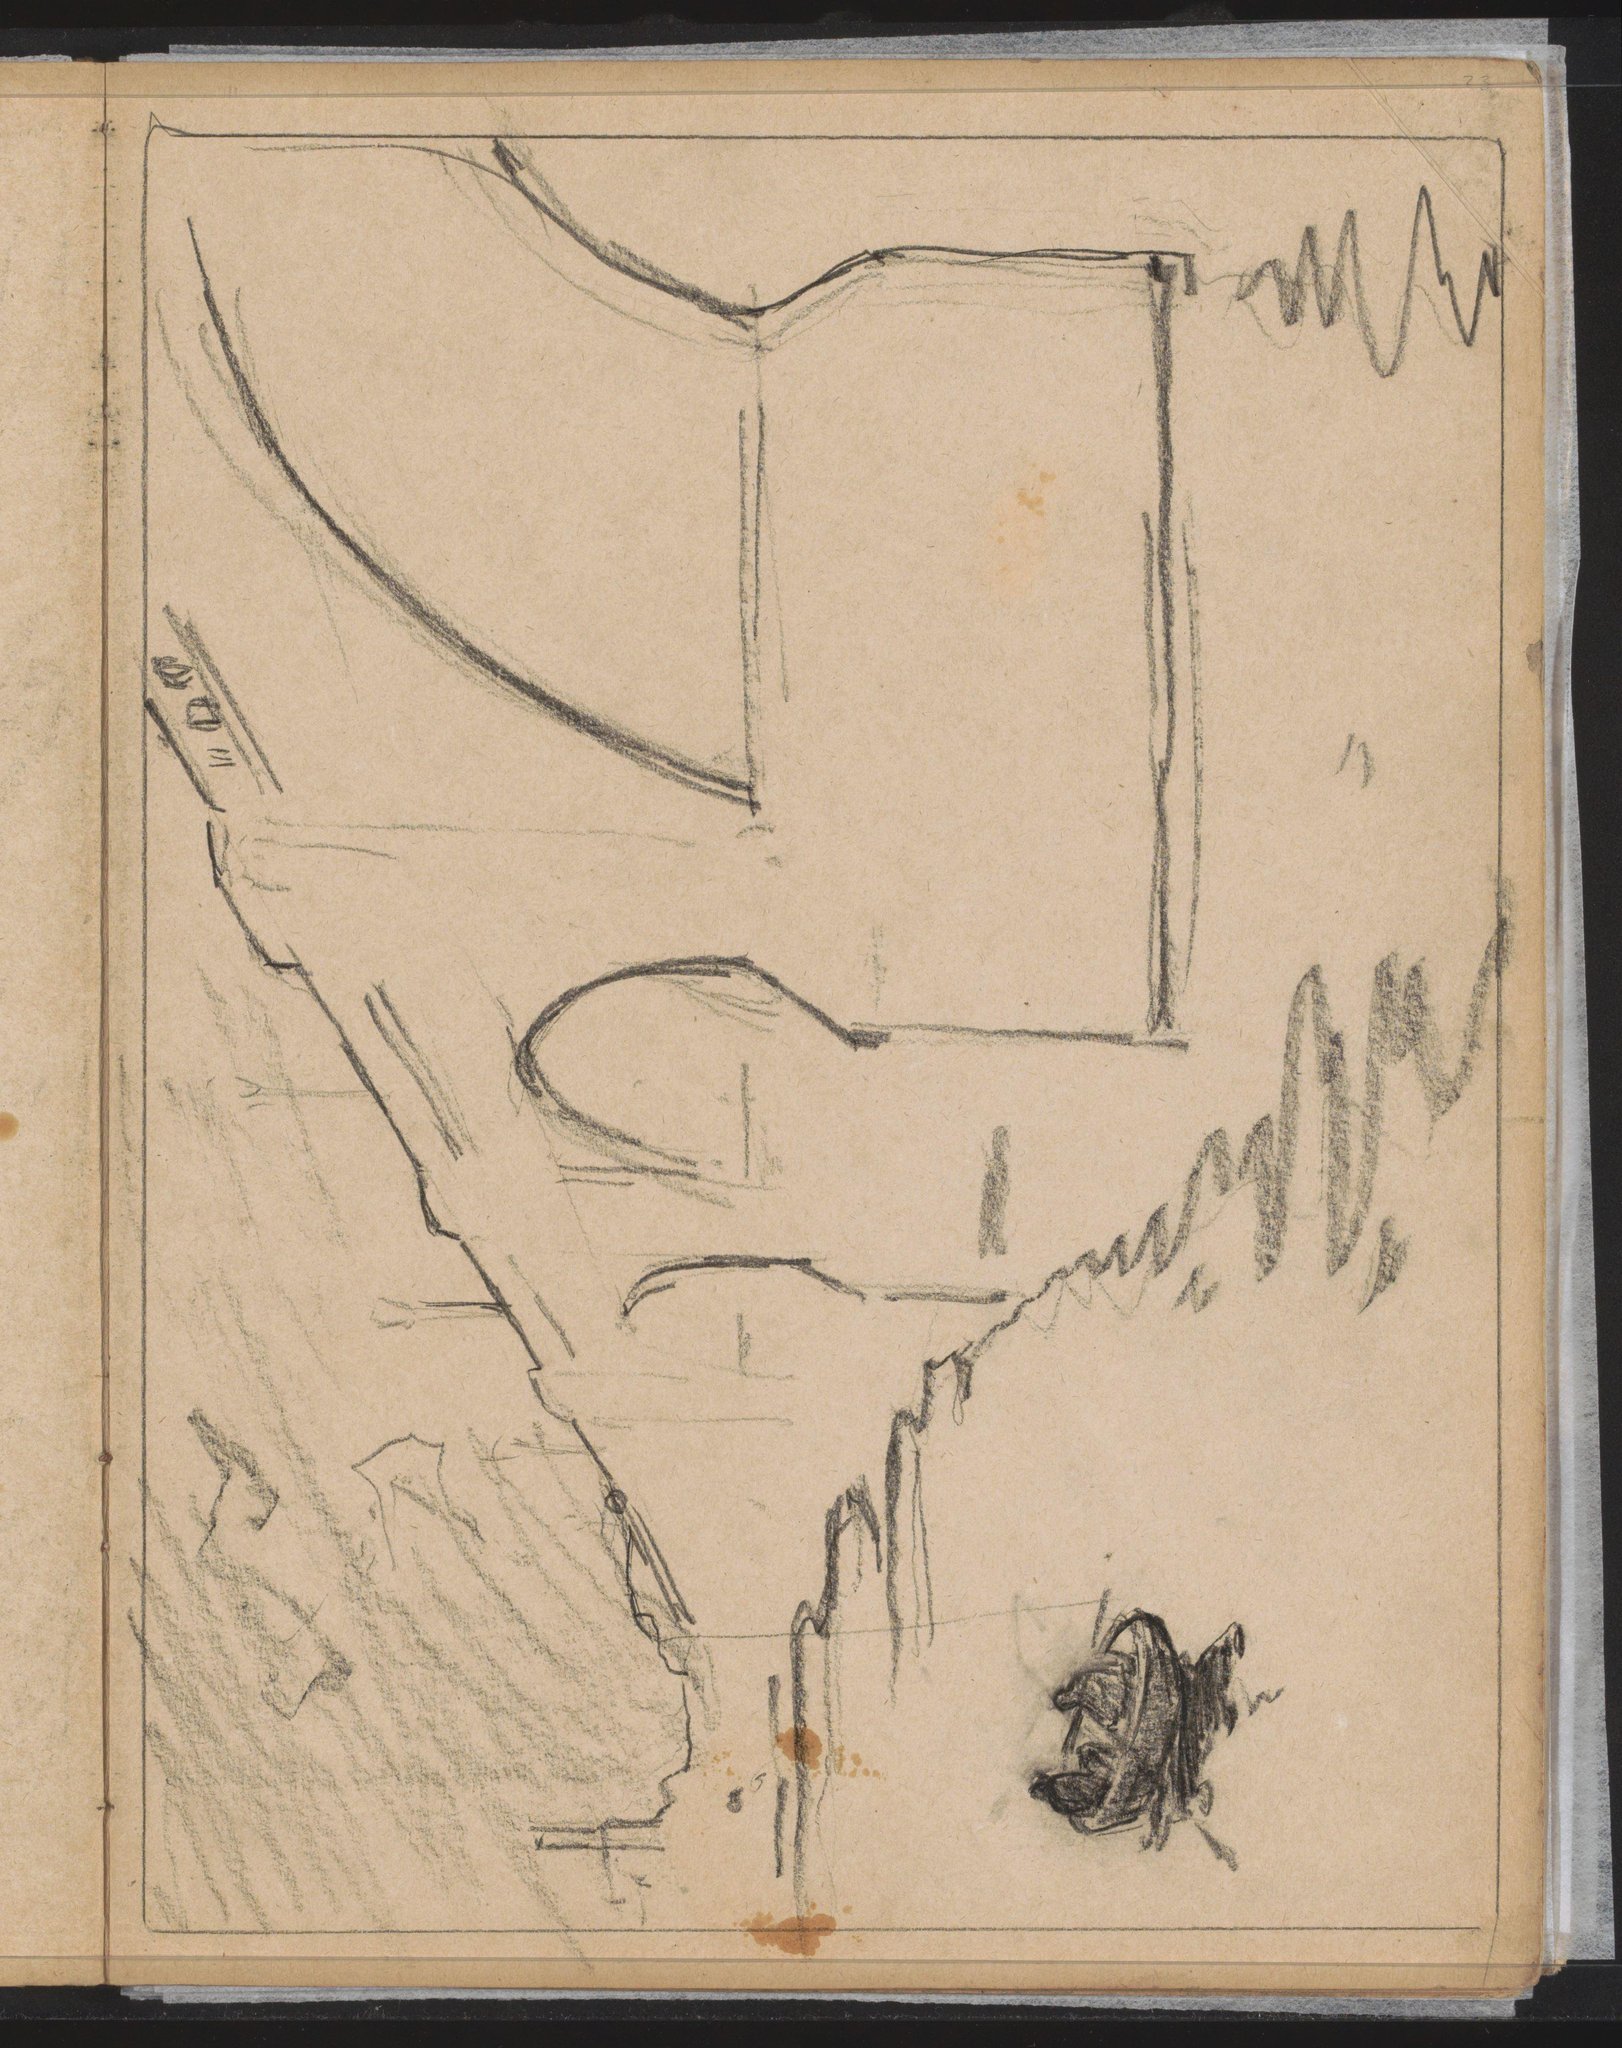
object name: sketchbook leaf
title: Gezicht op Waterloo Bridge te Londen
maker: willem witsen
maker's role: draughtsman, painter, print maker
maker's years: 1860-1923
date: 1888-1891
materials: chalk, paper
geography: london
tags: ships (in general), bridge in city across river, canal, etc., thames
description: Voorstudie voor de ets 'Waterloo Bridge in de mist, Londen', ca. 1890.